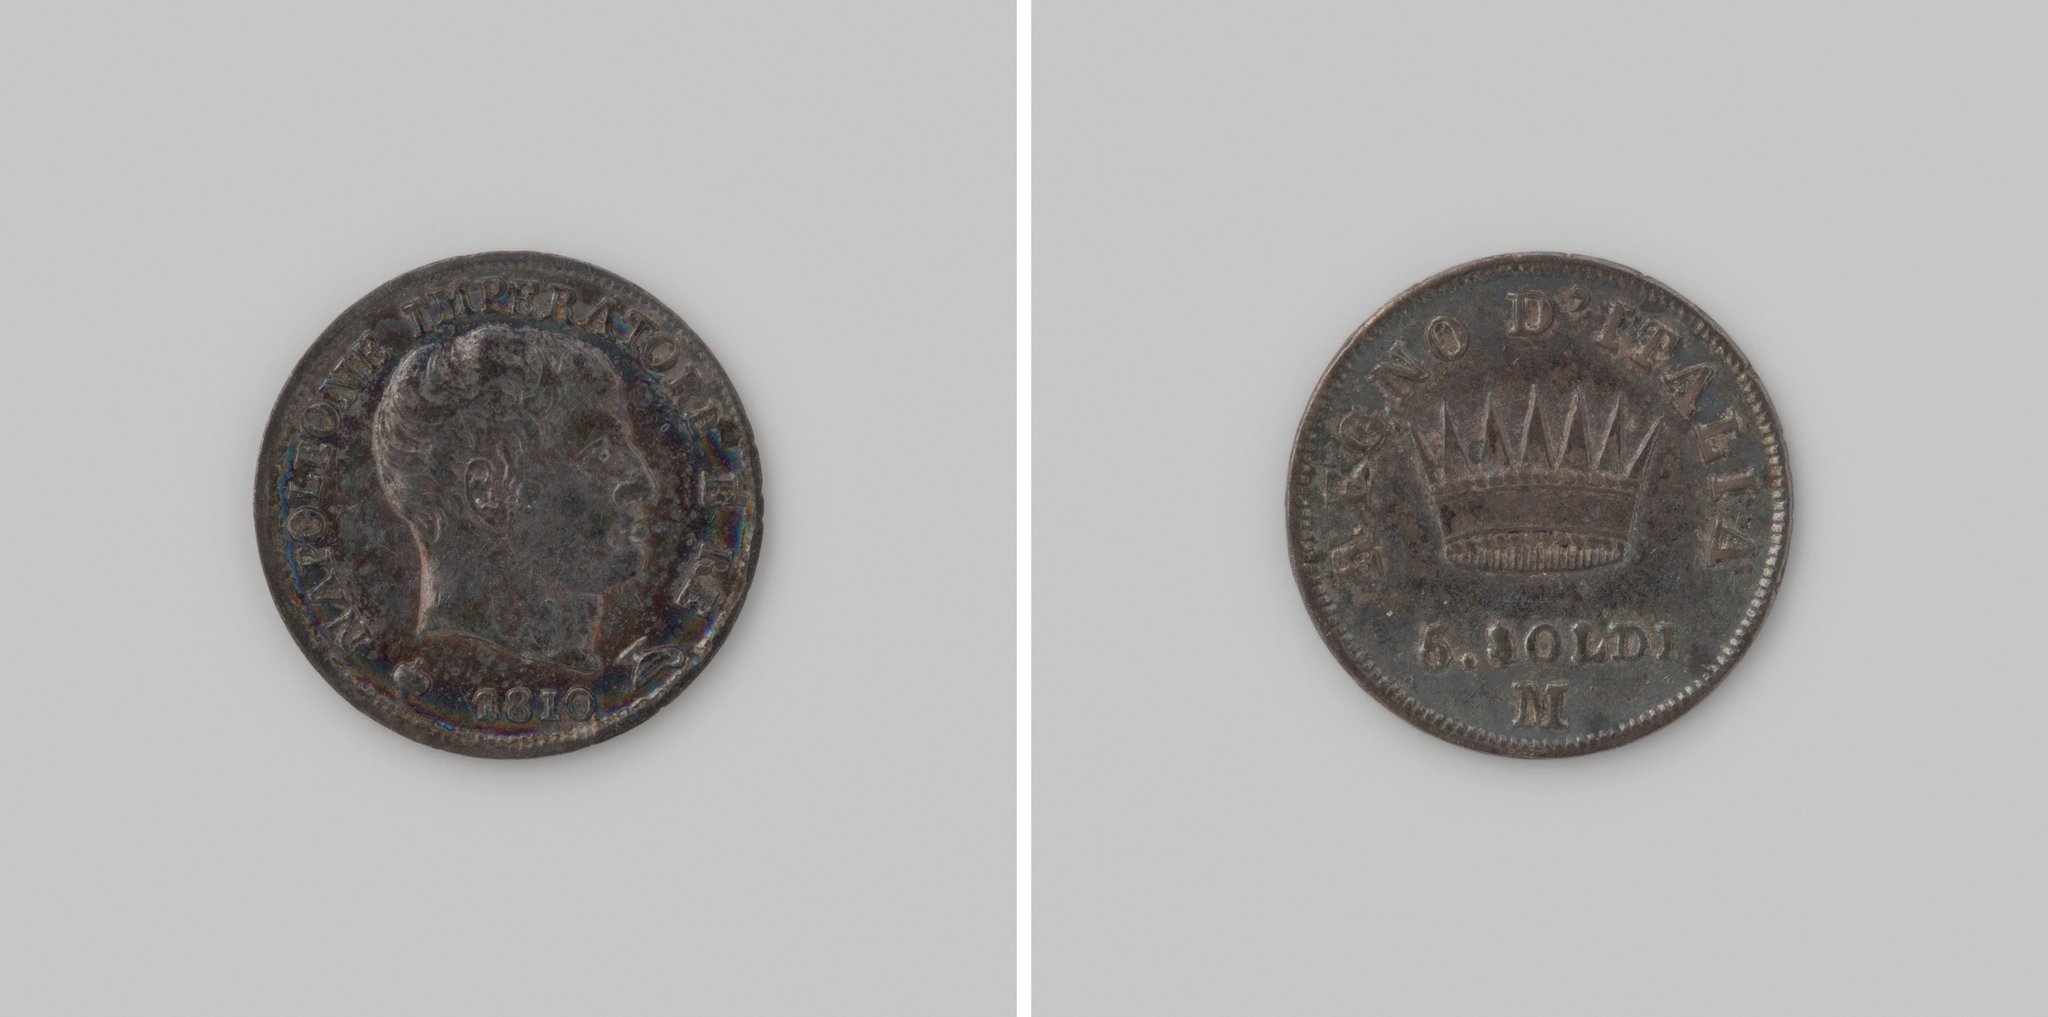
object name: coin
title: 5 soldi uit het koninkrijk Italië van Napoleon als koning, 1810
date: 1810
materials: silver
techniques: striking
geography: milan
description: Zilveren munt. Voorzijde: hoofd van Napoleon naar rechts. Keerzijde: kroon, waaronder waarde-aanduiding in een regel. Daaronder letter M [=Milaan]. In rand sterretjes.